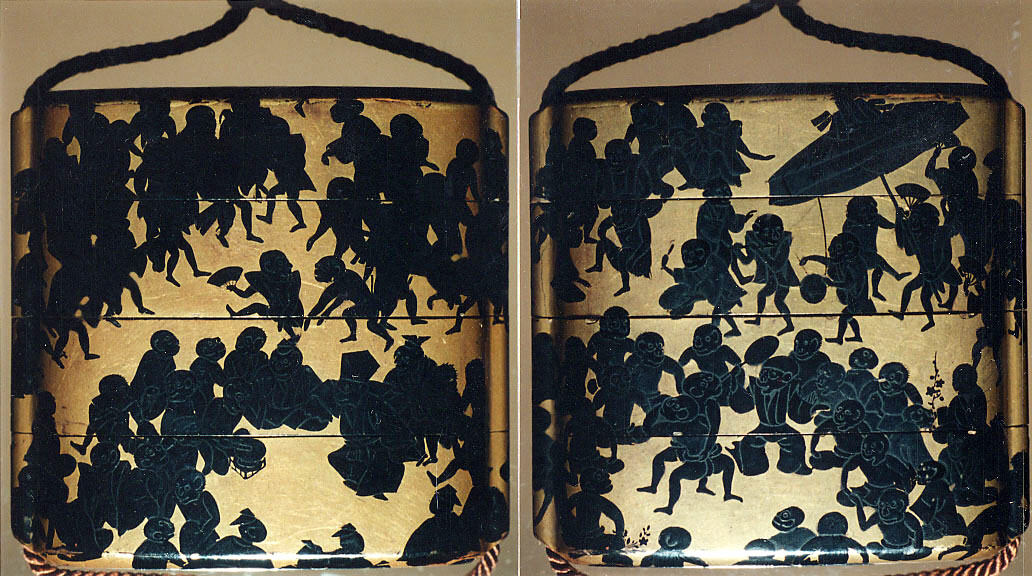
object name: inrō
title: Case (Inrō) with Design of Monkeys' Festival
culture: japanese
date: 1701-1900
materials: wood, gold, ivory, lacquer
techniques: carving, lacquer, maki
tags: dancing,monkeys,wrestling